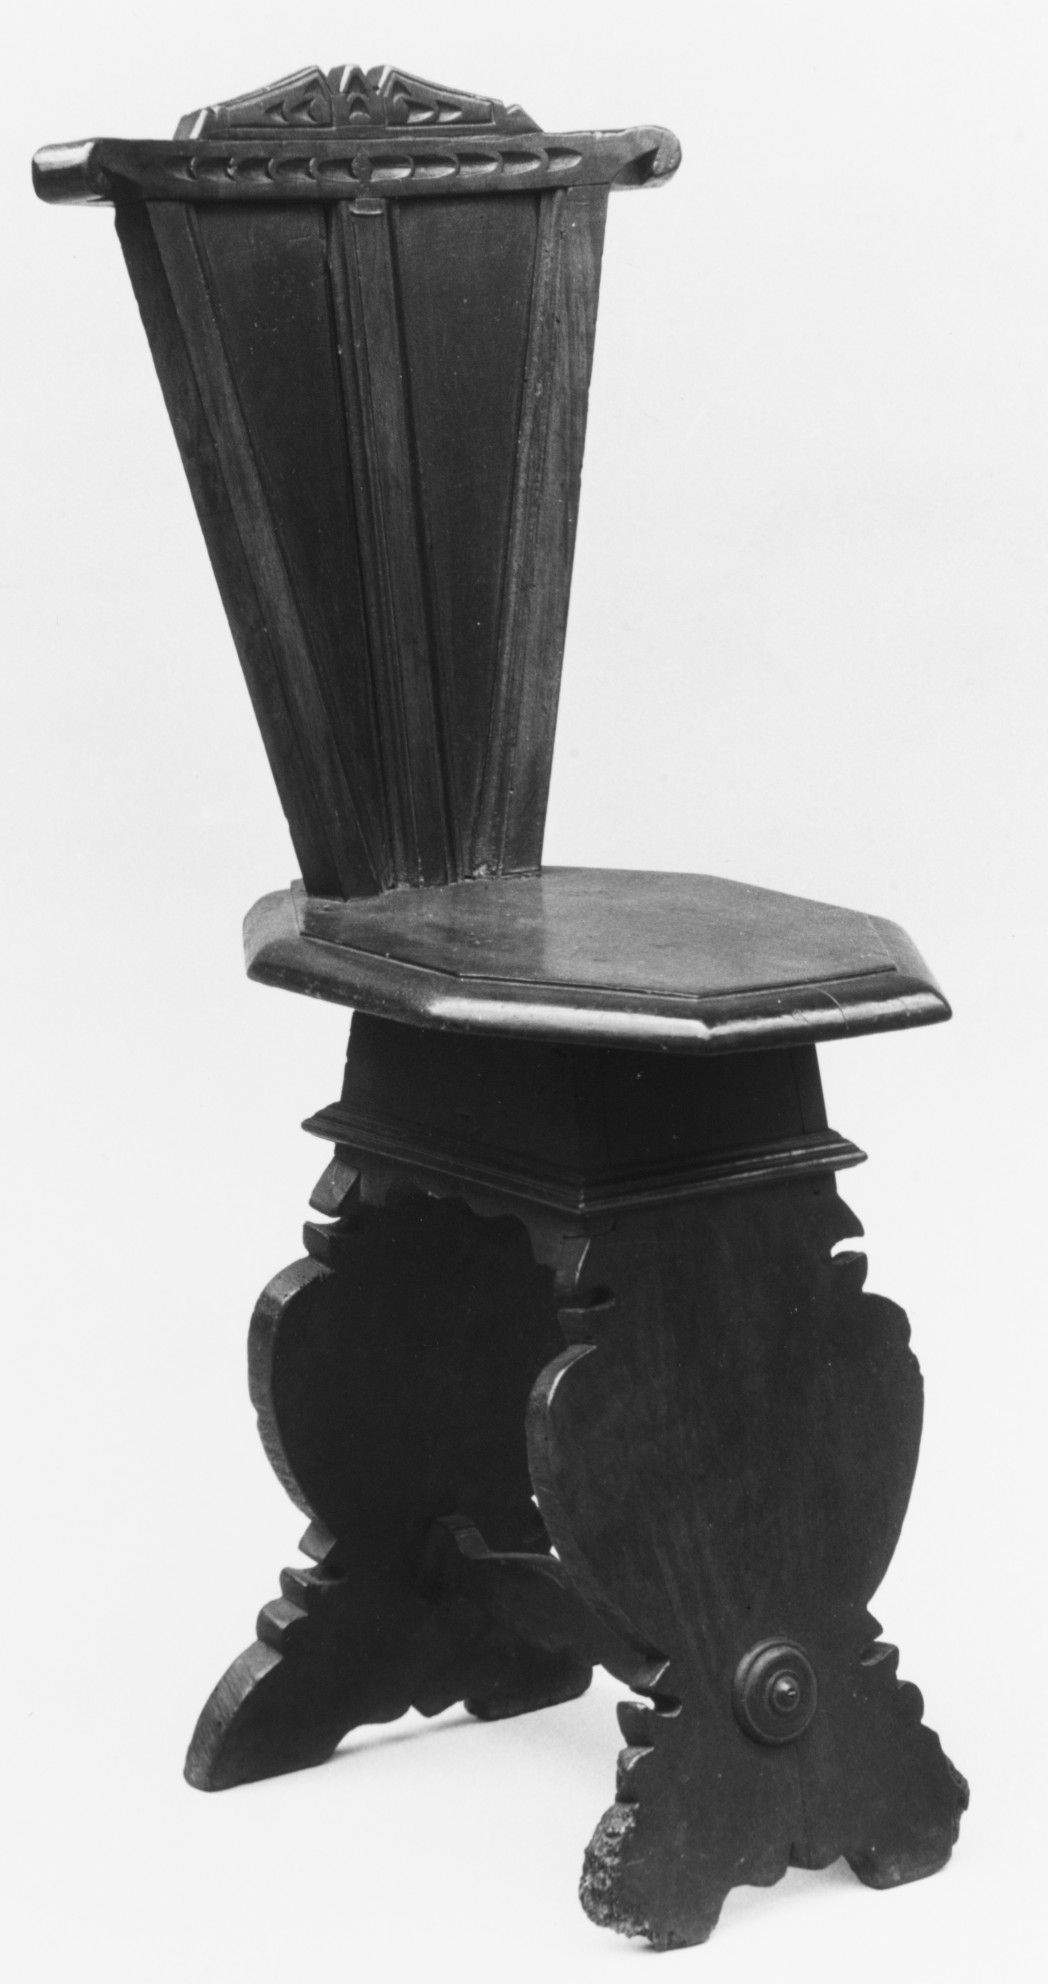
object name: sgabello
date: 1501-1600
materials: wood